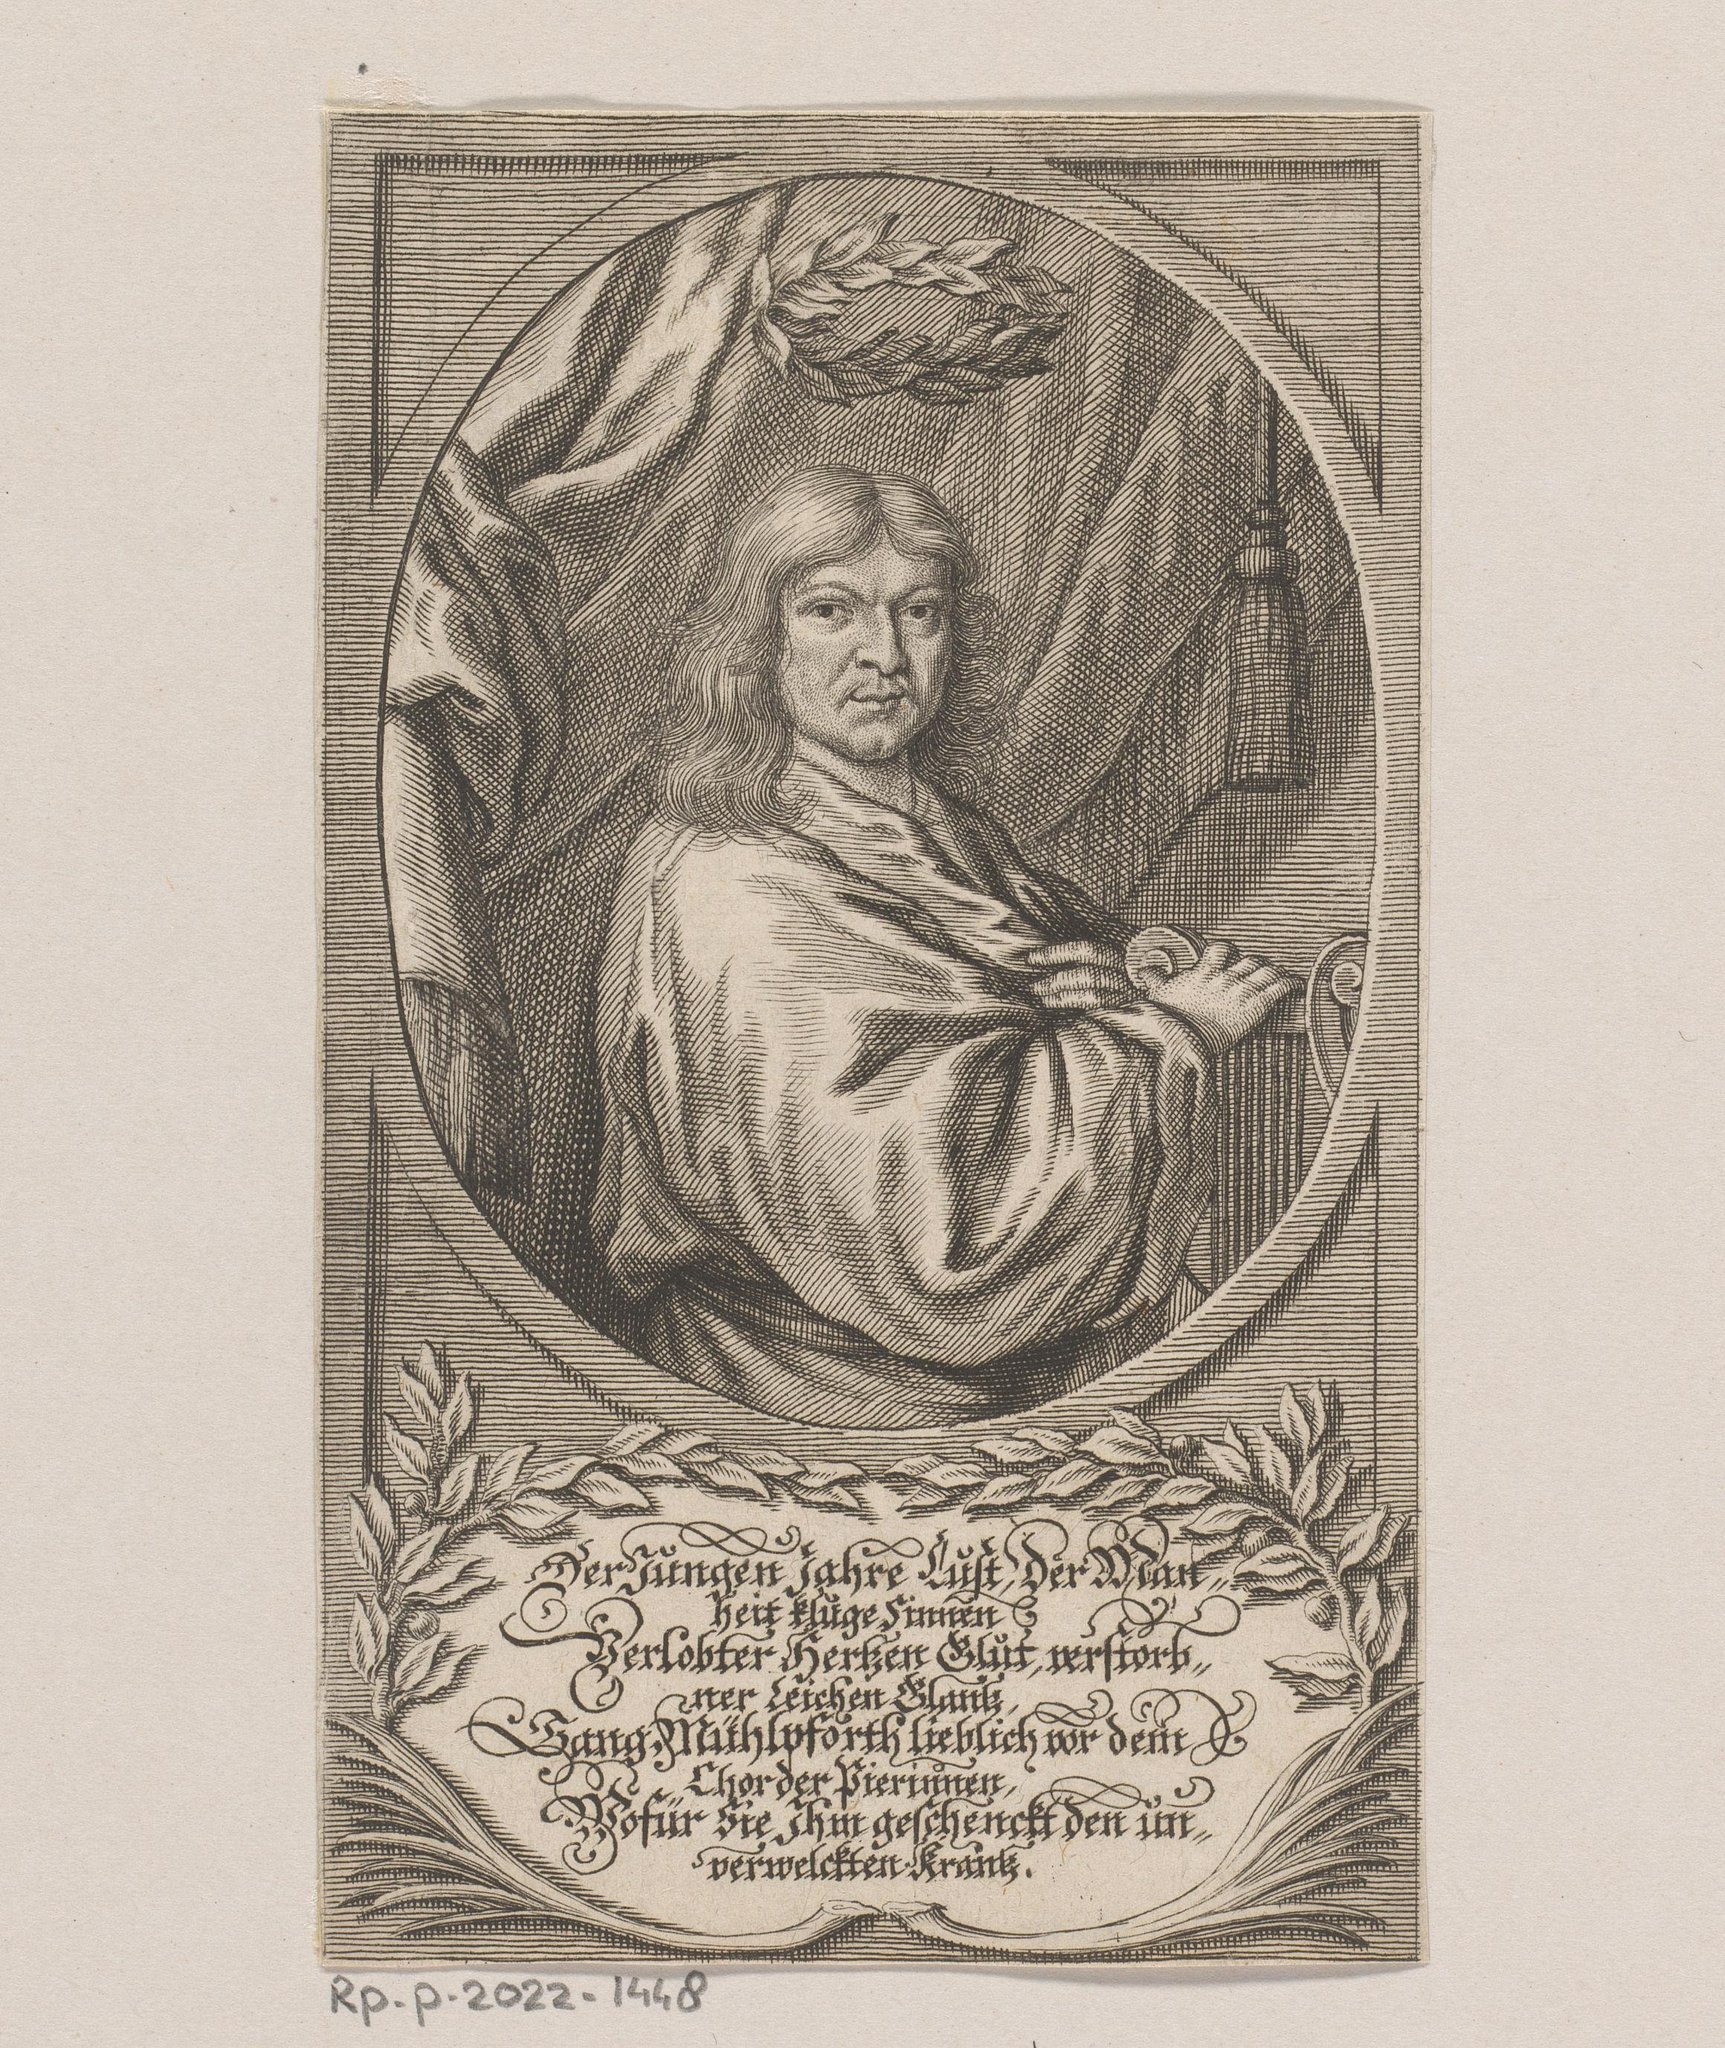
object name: print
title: Portret van Heinrich Mühlpfort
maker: jakob von sandrart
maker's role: print maker, publisher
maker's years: 1630-1708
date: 1698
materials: paper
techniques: engraving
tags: heinrich mühlpfort, historical persons, portrait of a writer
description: Prent waarschijnlijk uit: Mühlpforth, Heinrich. Teutsche Gedichte. Breslau: Johann Georg Steck, 1698.